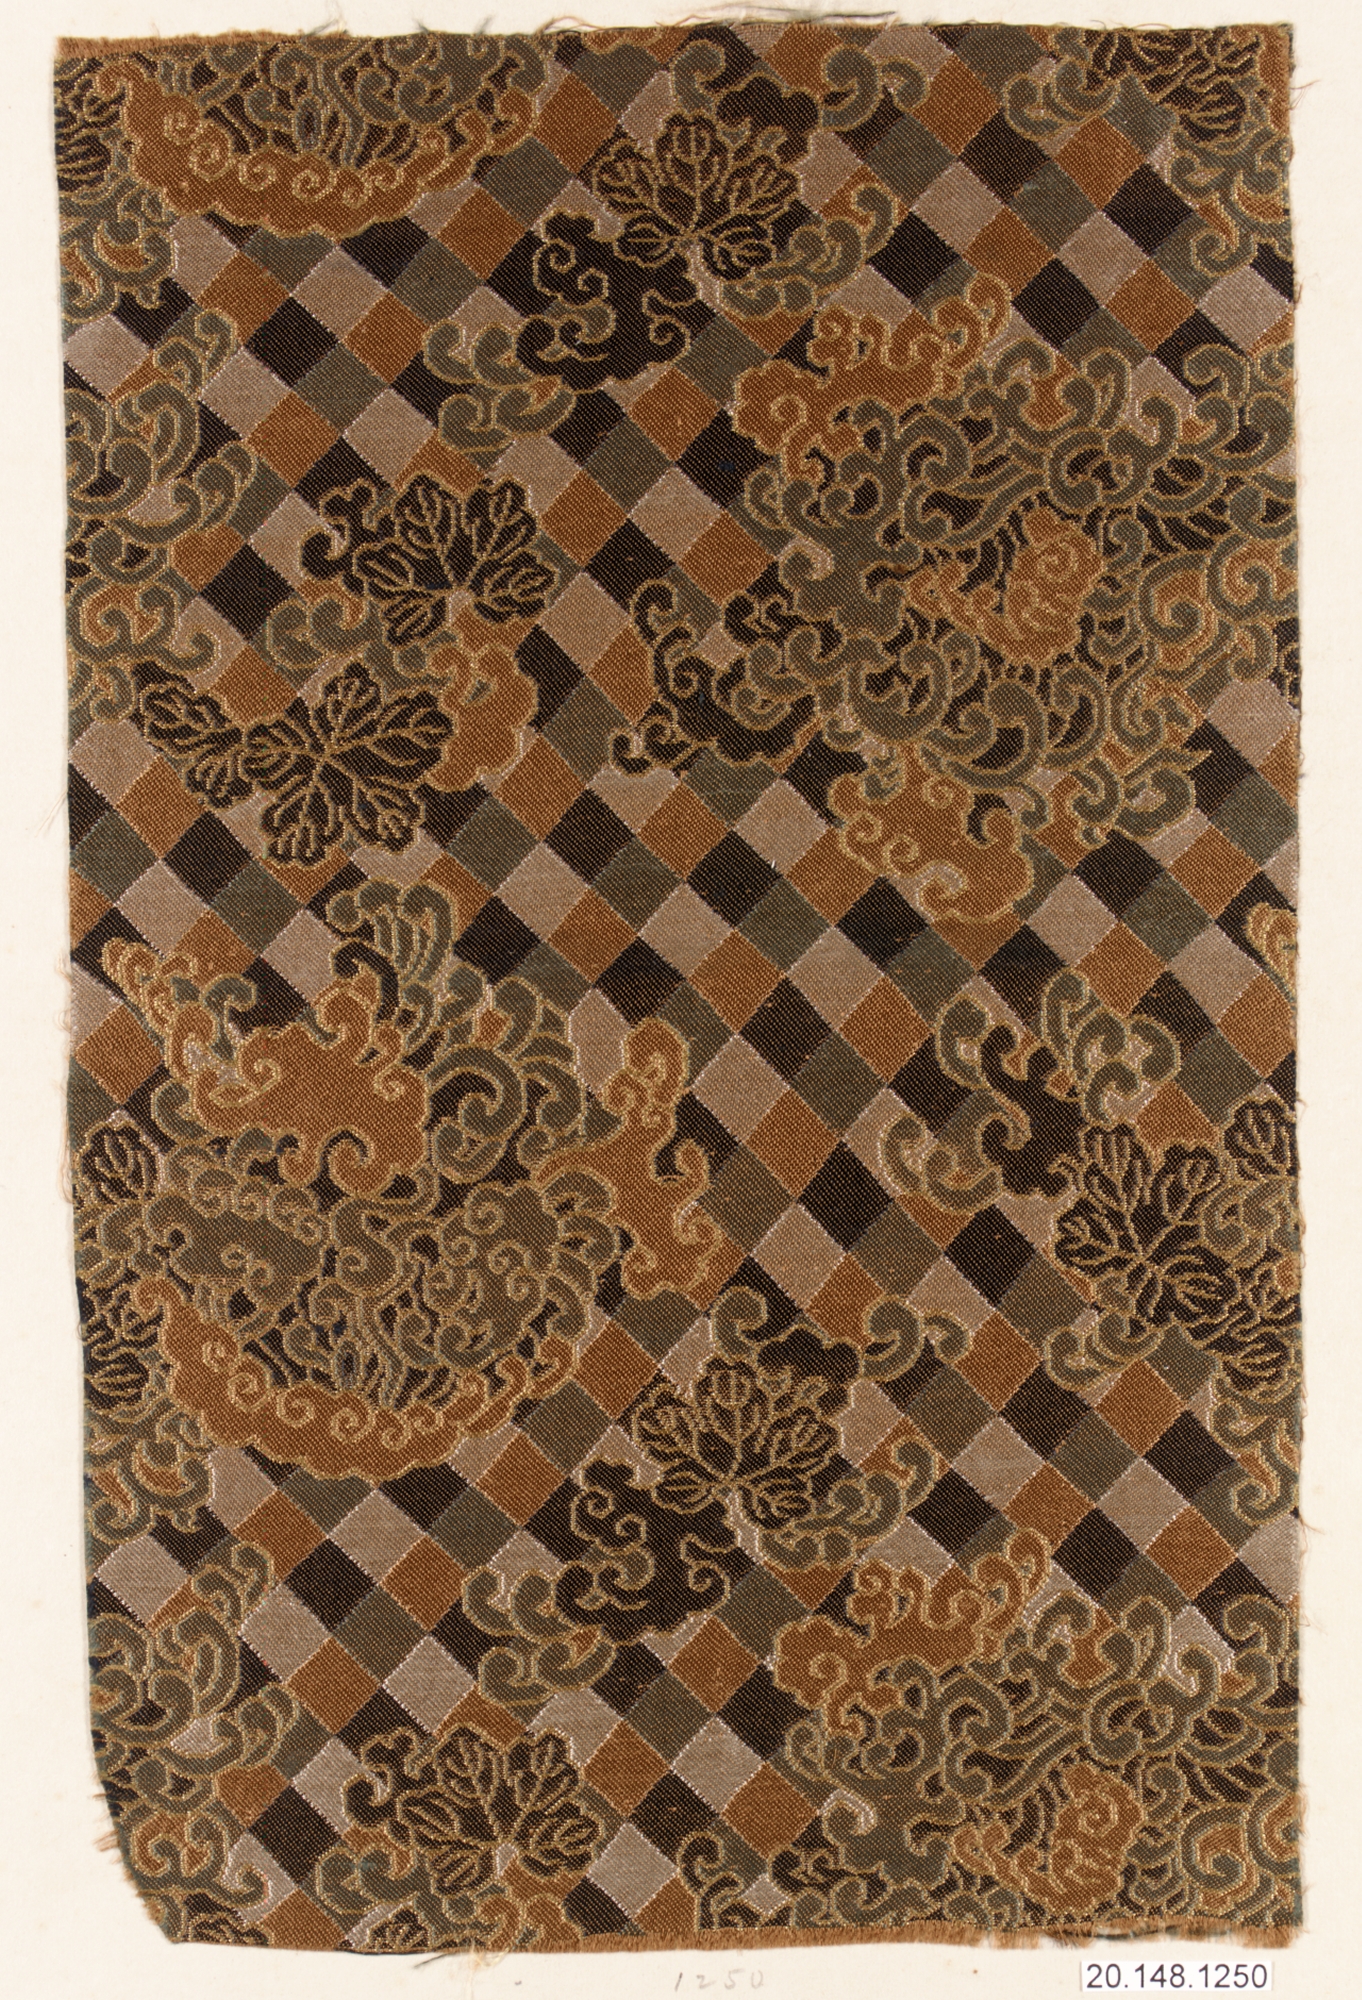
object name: piece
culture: japanese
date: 1801-1900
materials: silk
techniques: compound weave